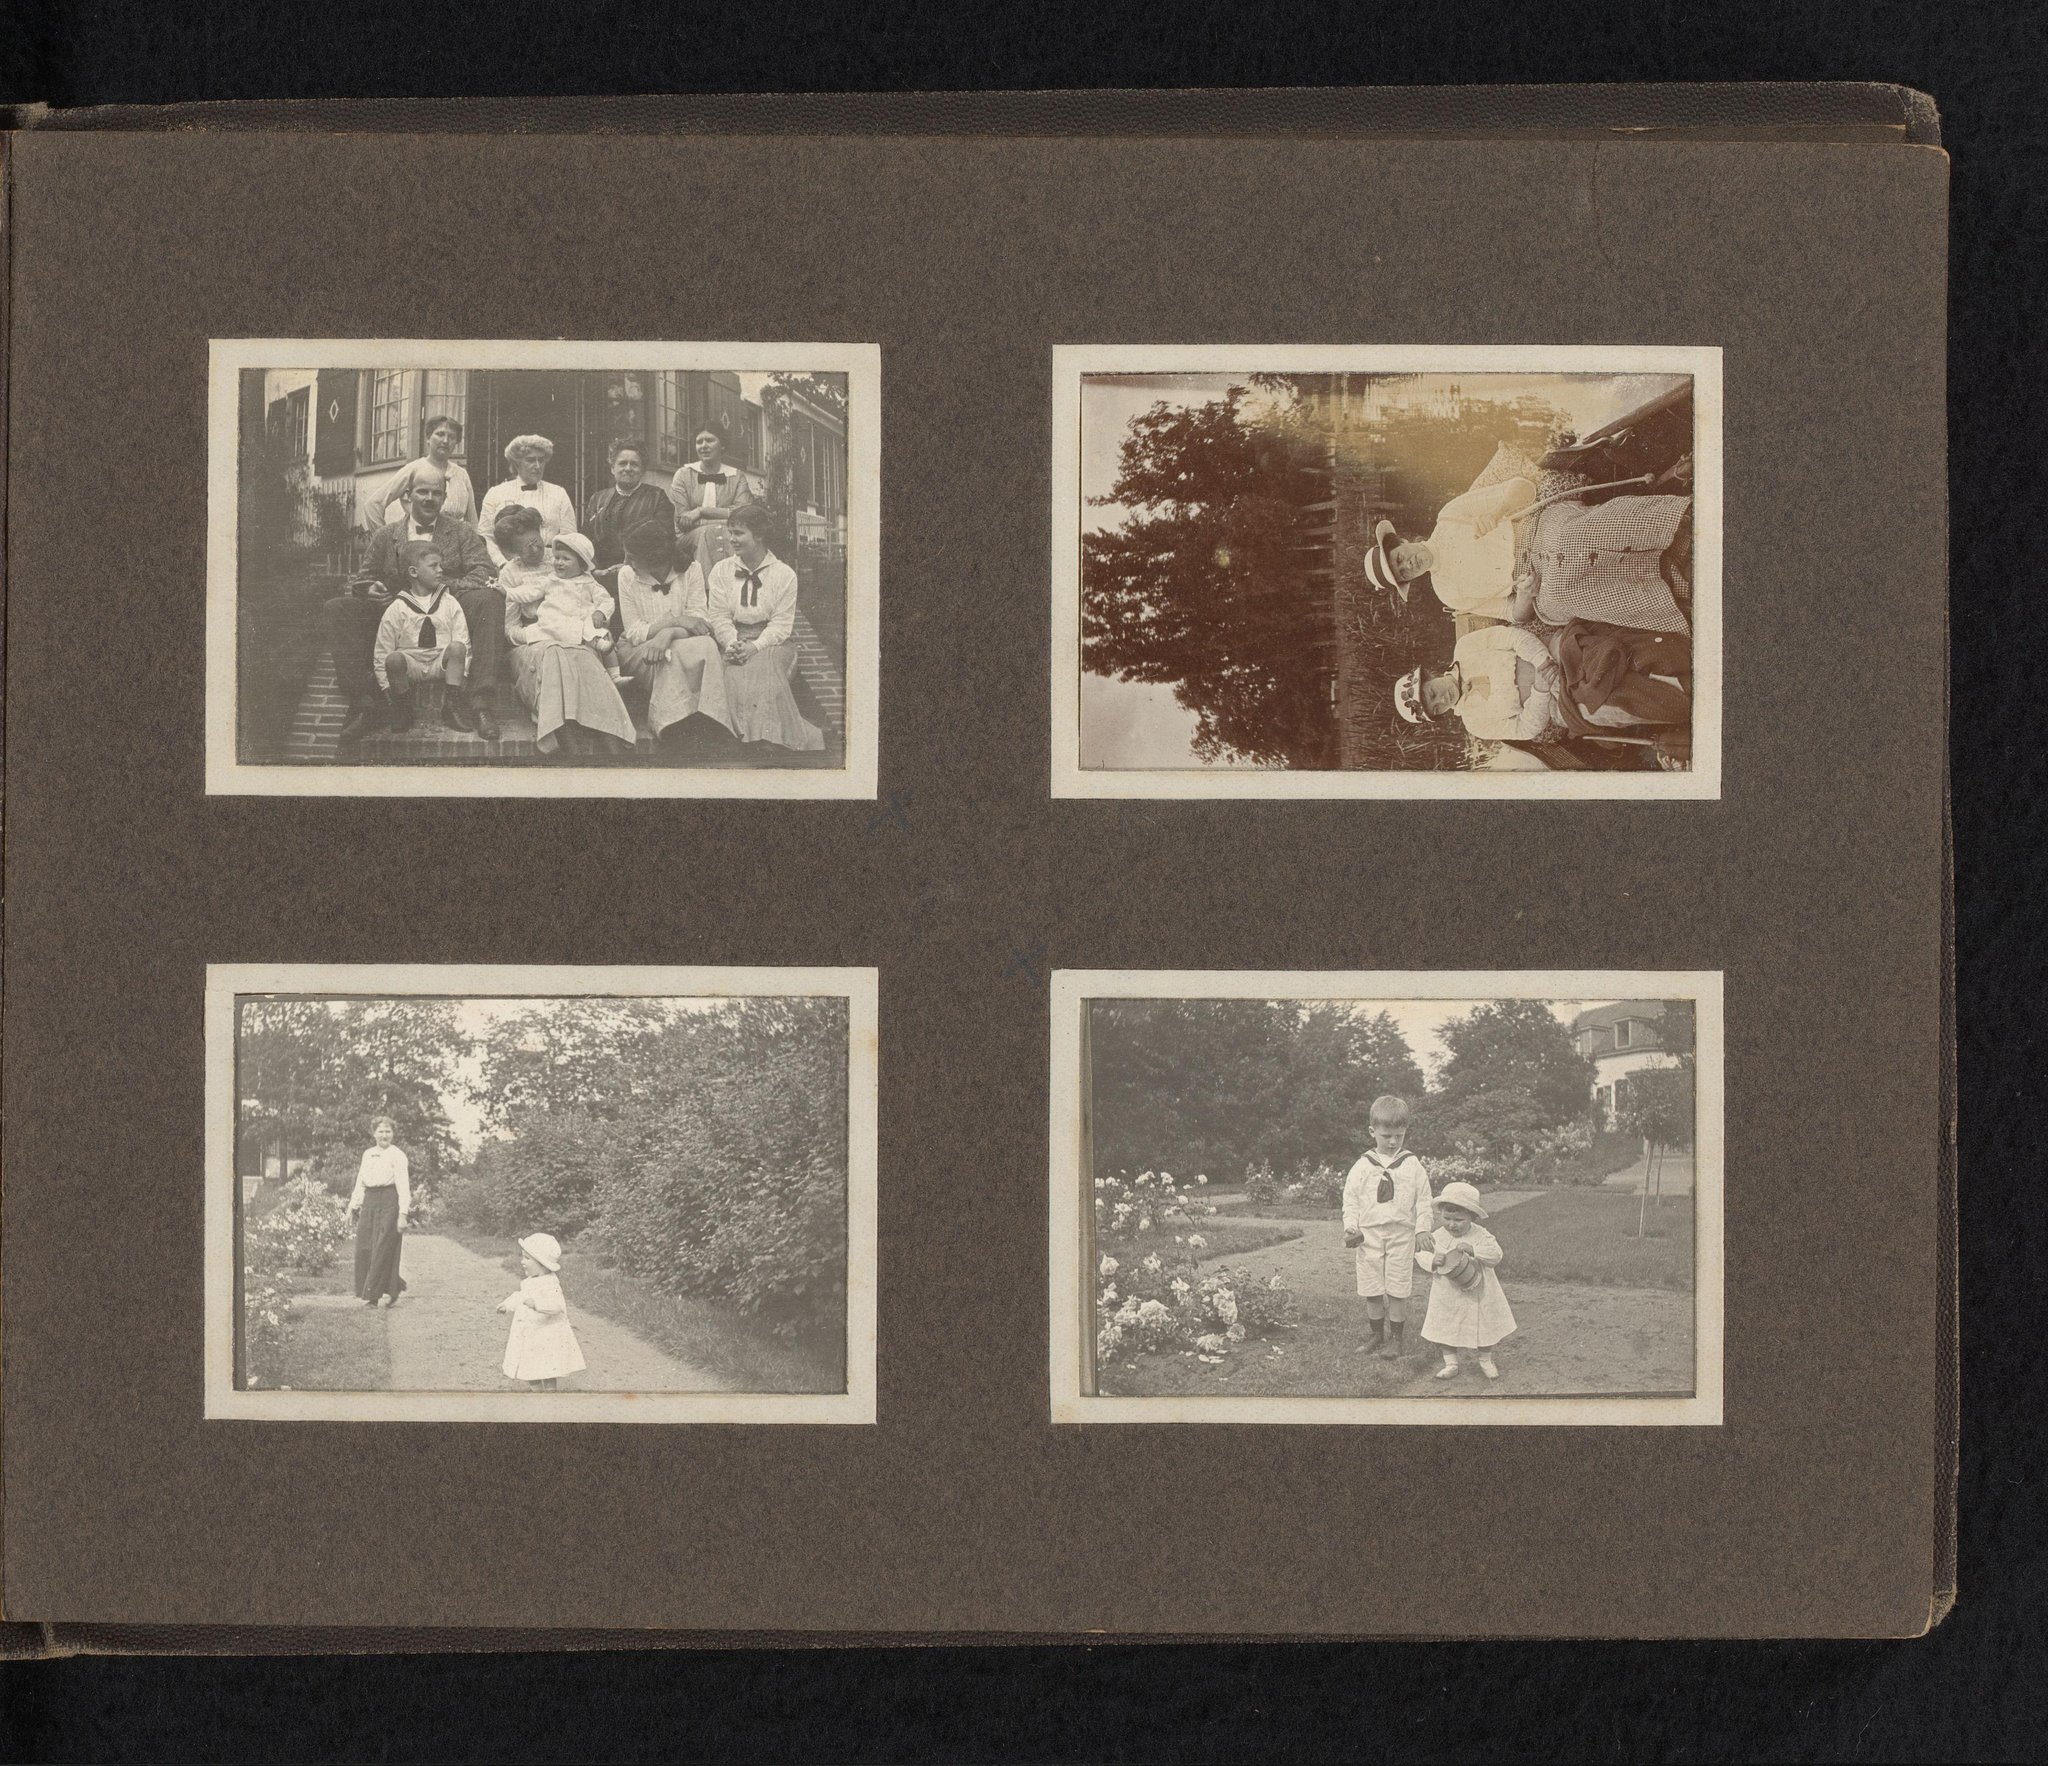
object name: photograph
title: Vier foto's van de familie Van den Berg met anderen in Bergerac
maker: hendrik herman van den berg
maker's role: amateurfotograaf, jurist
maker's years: 1875-1944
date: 1914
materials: paper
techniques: gelatin silver print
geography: bergerac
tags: batavia, hendrik herman van den berg, the hague, caroline louise van den berg-van den berg, carel frederik van den berg (cay), amsterdam, frank willem van den berg (1912-1998), the family travelling, on holiday, family group, especially parents with their child(ren)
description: Deze foto's maken deel uit van een album.